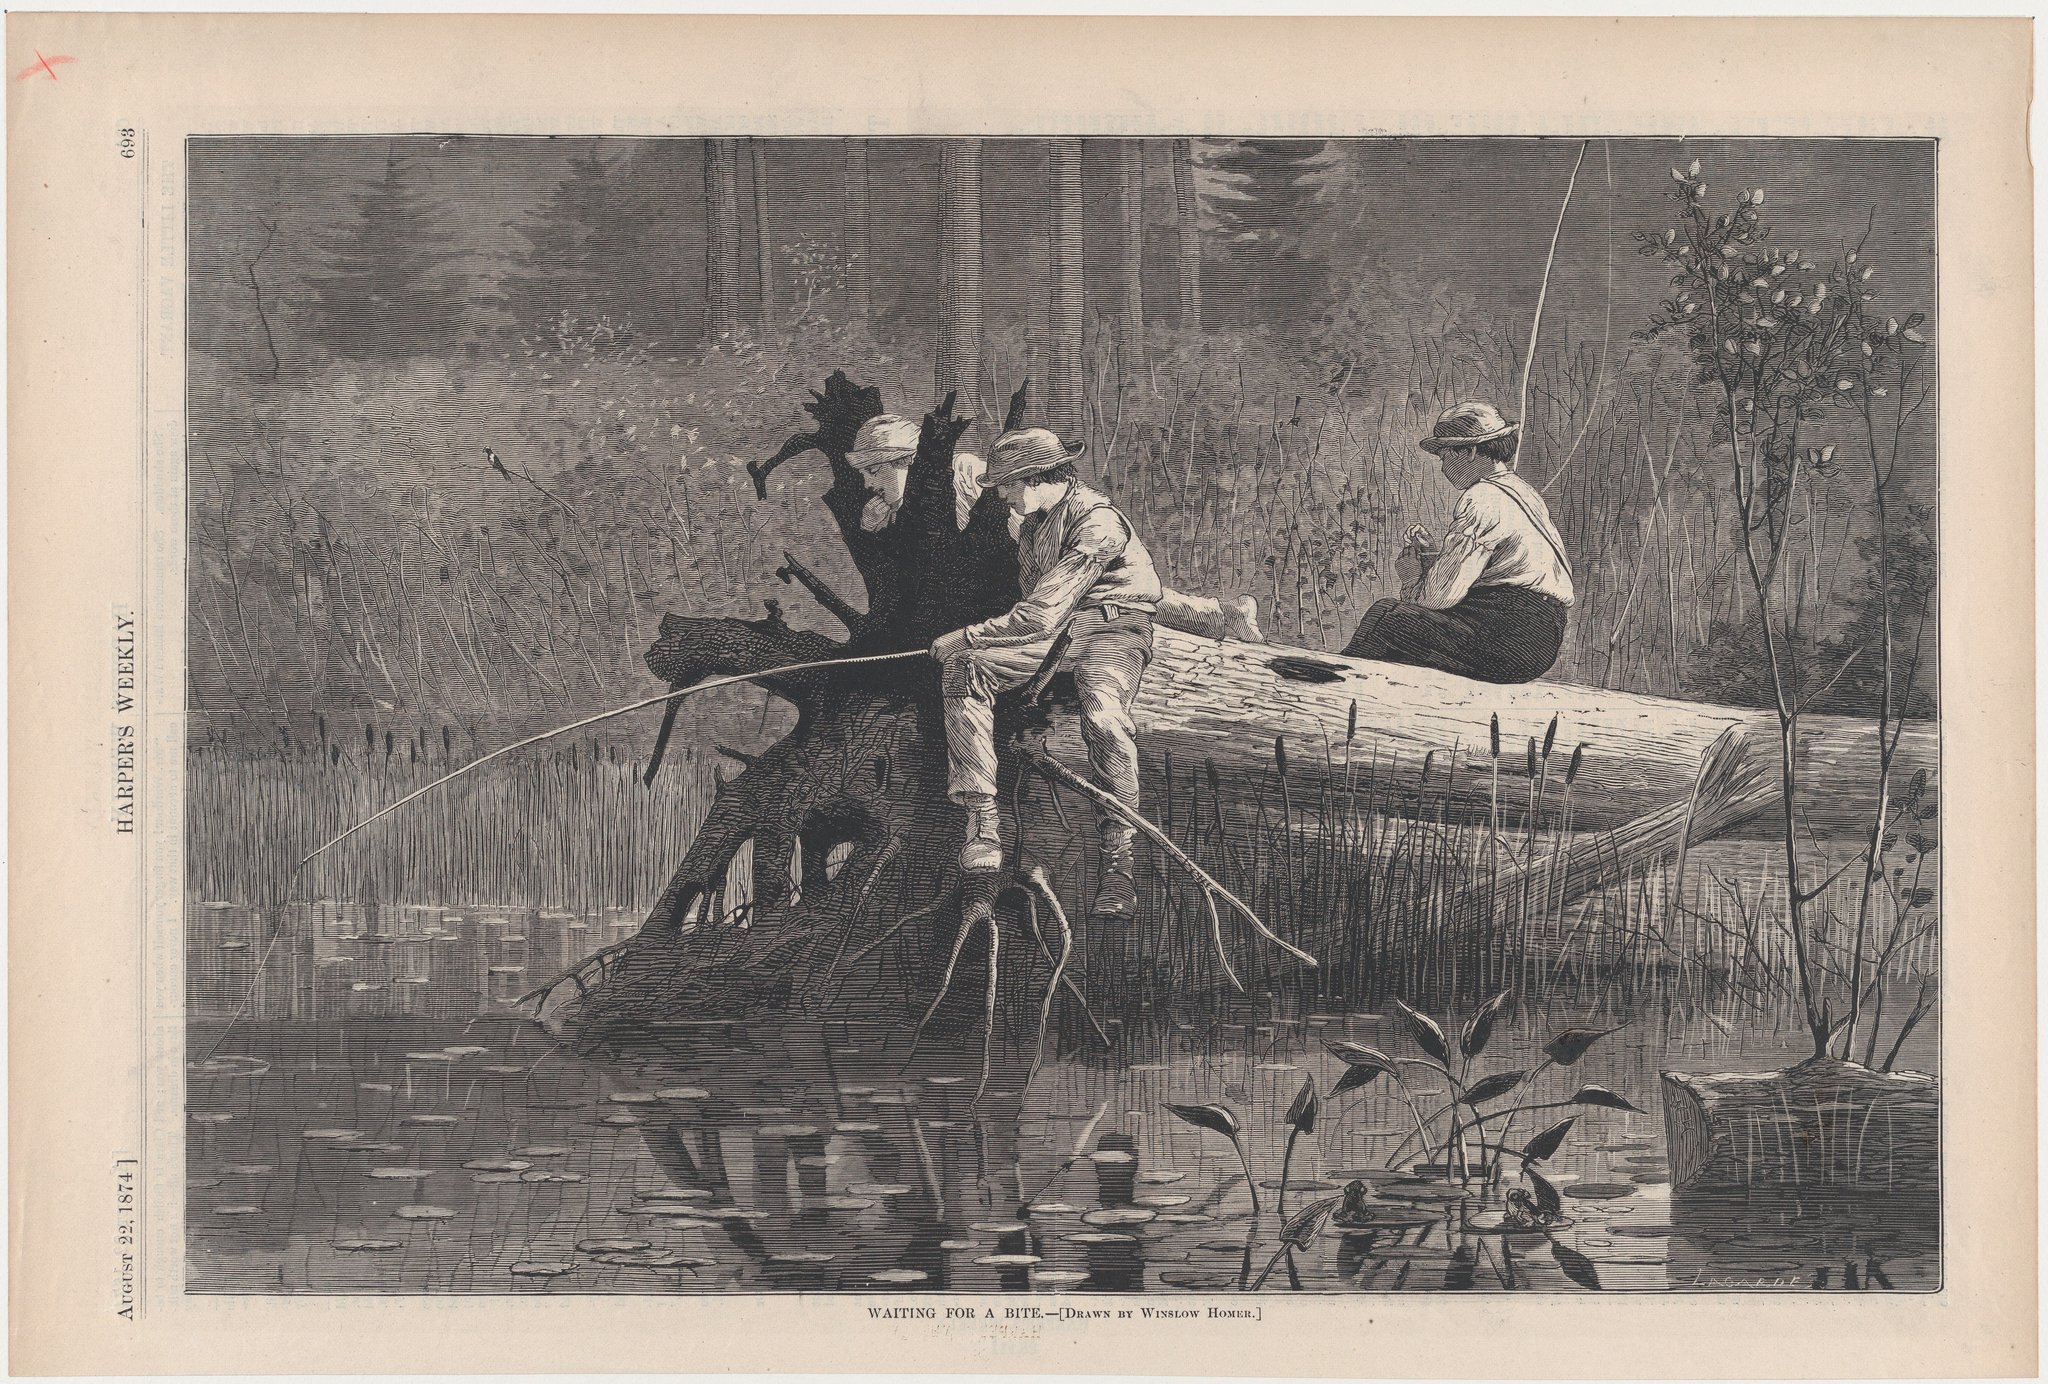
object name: print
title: Waiting for a Bite (from "Harper's Weekly," Vol. XVIII)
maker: winslow homer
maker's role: artist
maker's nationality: american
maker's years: 1836-1910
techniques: engraving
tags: boys,fishing